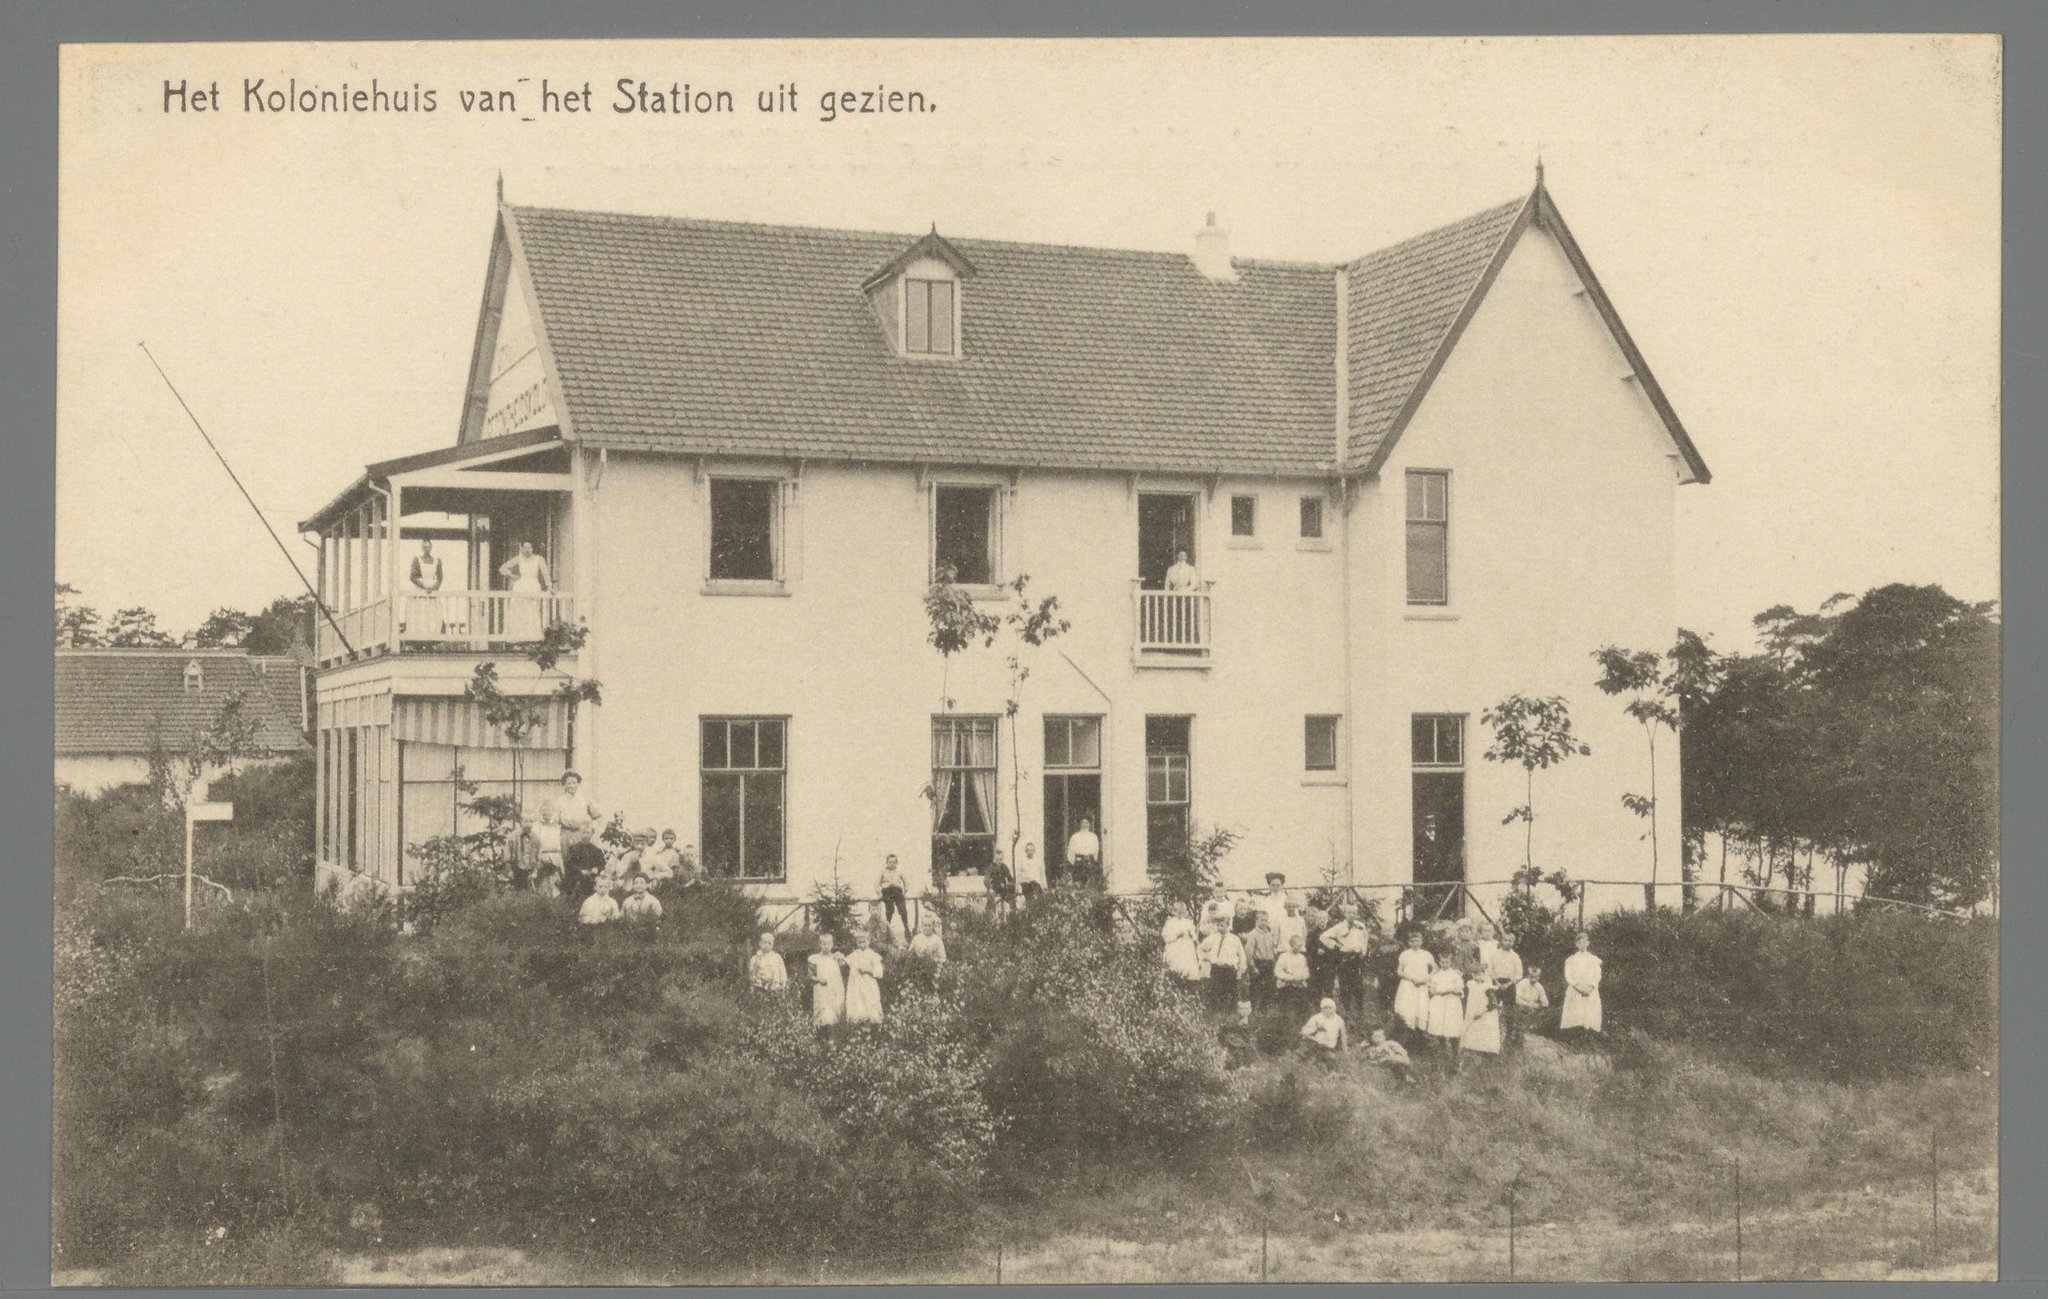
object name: photomechanical print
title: Het Koloniehuis van het station uit gezien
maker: Anonymous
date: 1905-1915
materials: cardboard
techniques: photograph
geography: bosch en duin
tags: villa, recovery, convalescence of sick person